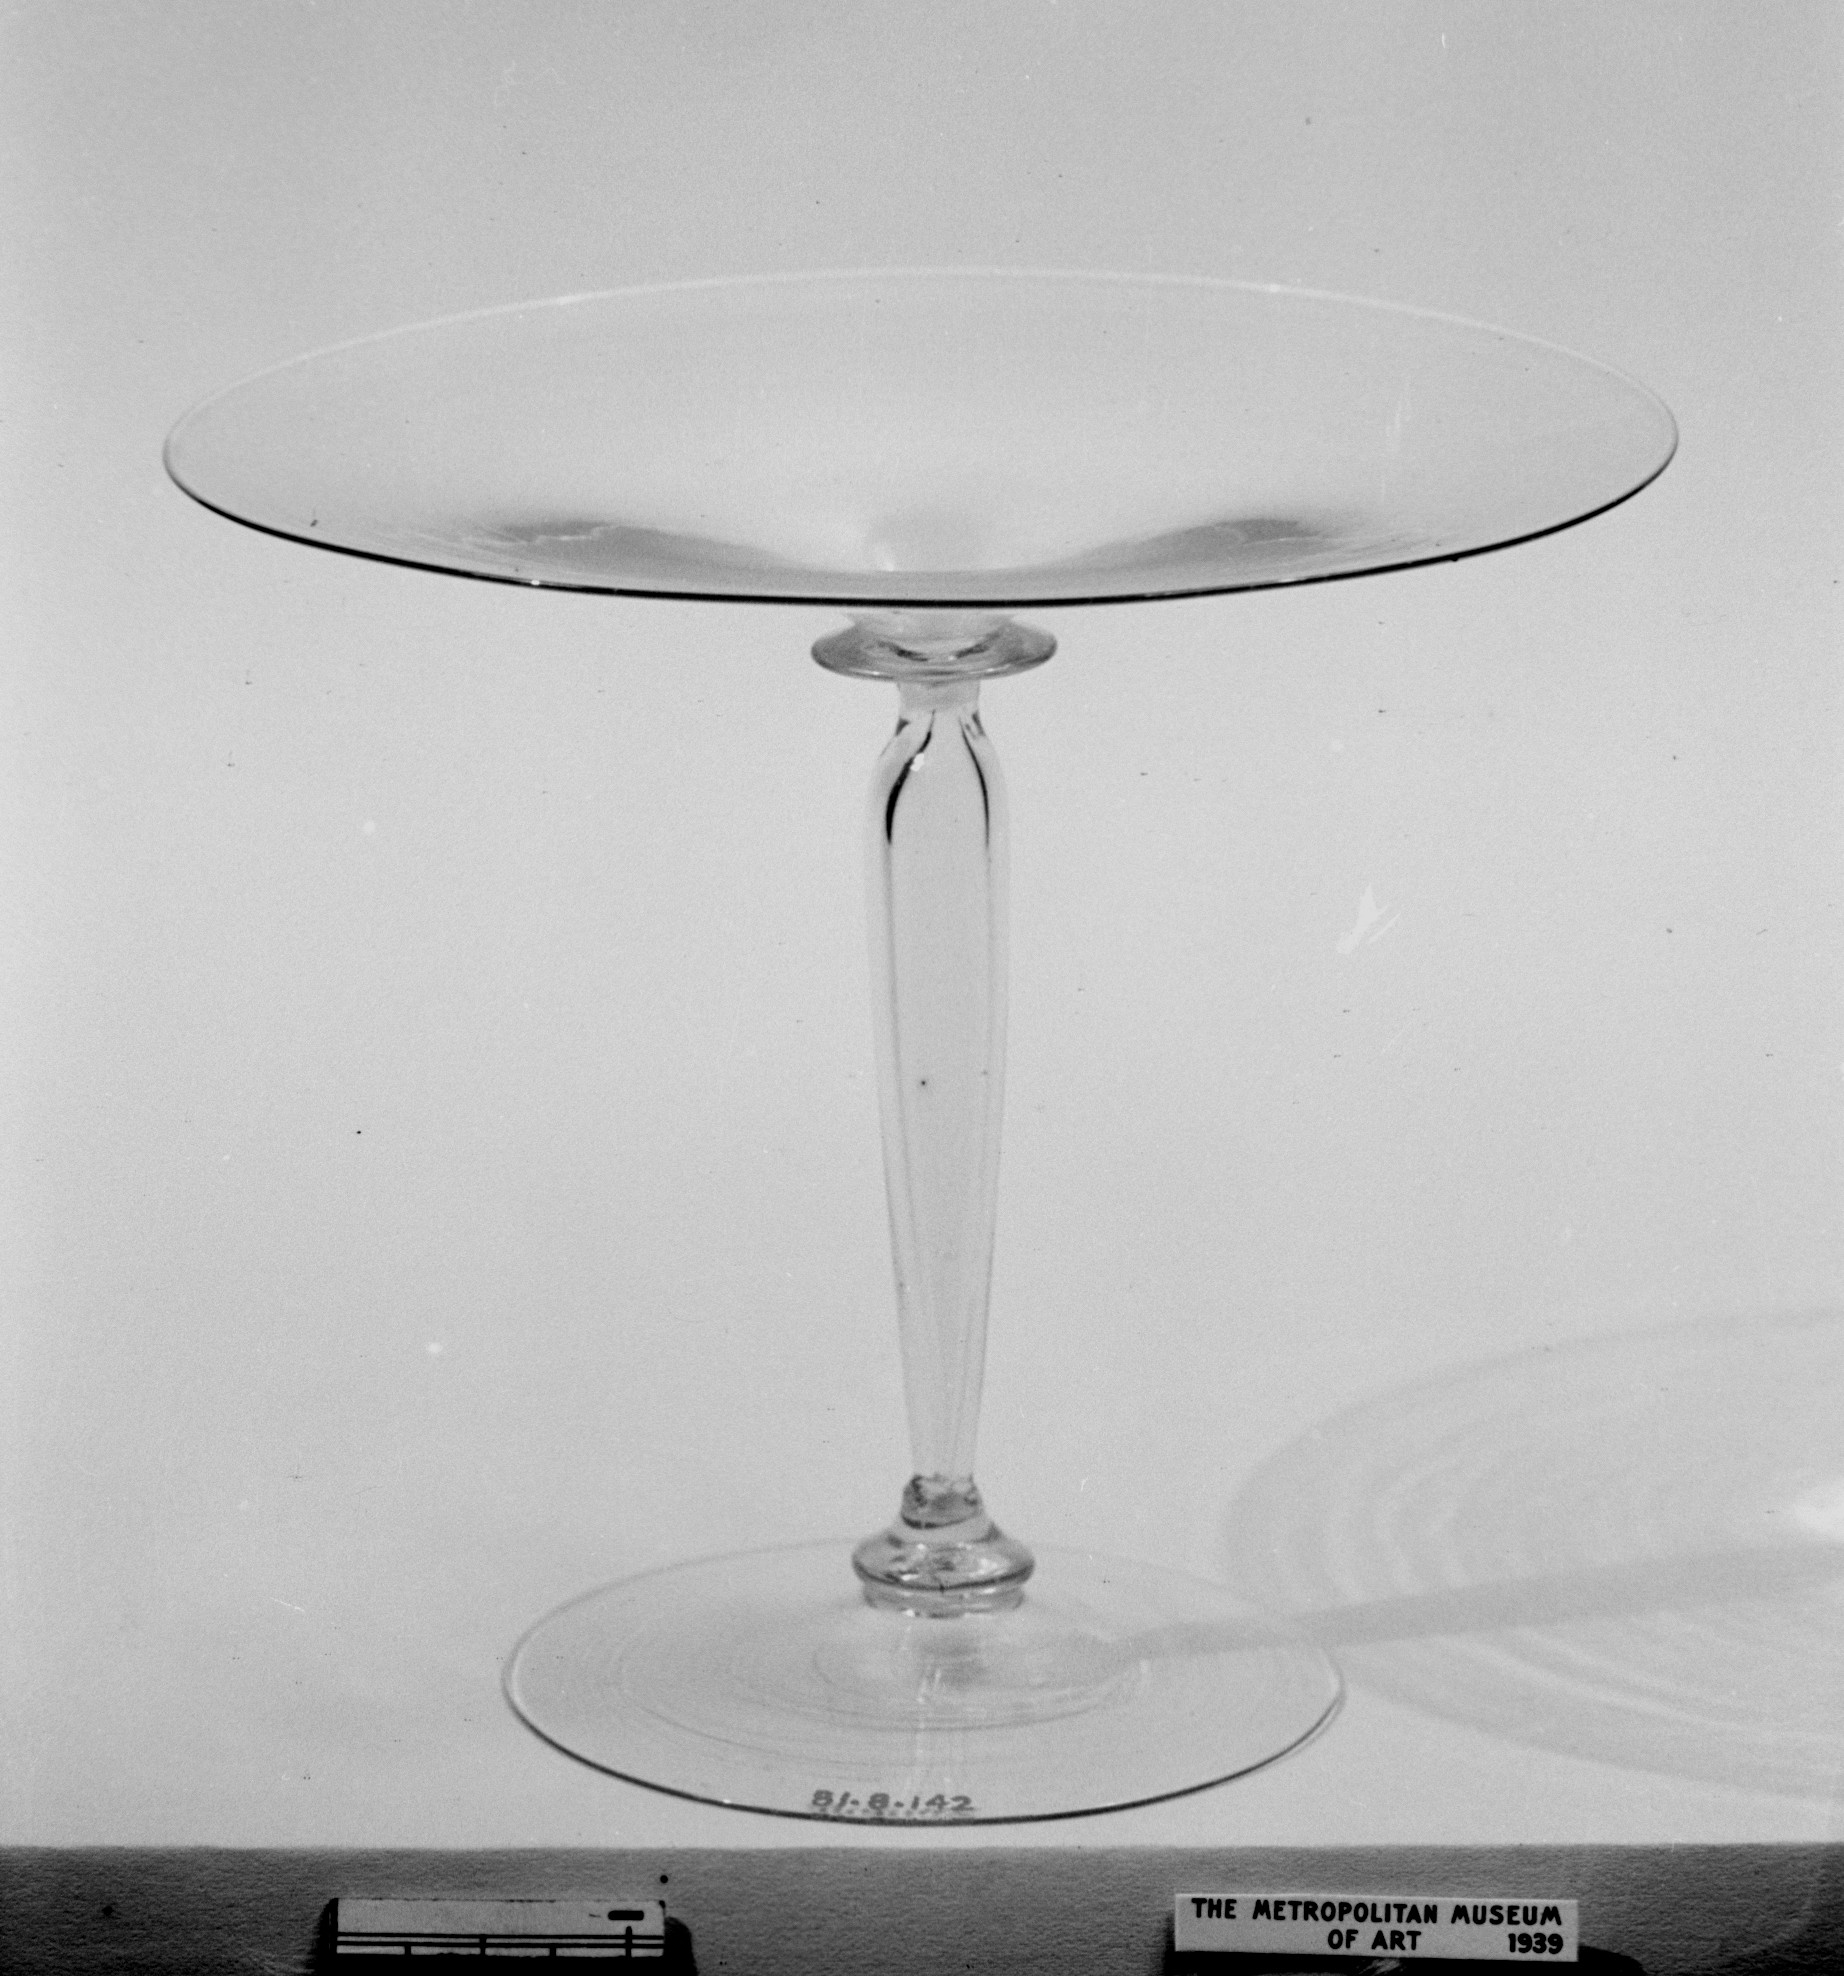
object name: tazza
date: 1567-1600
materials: glass